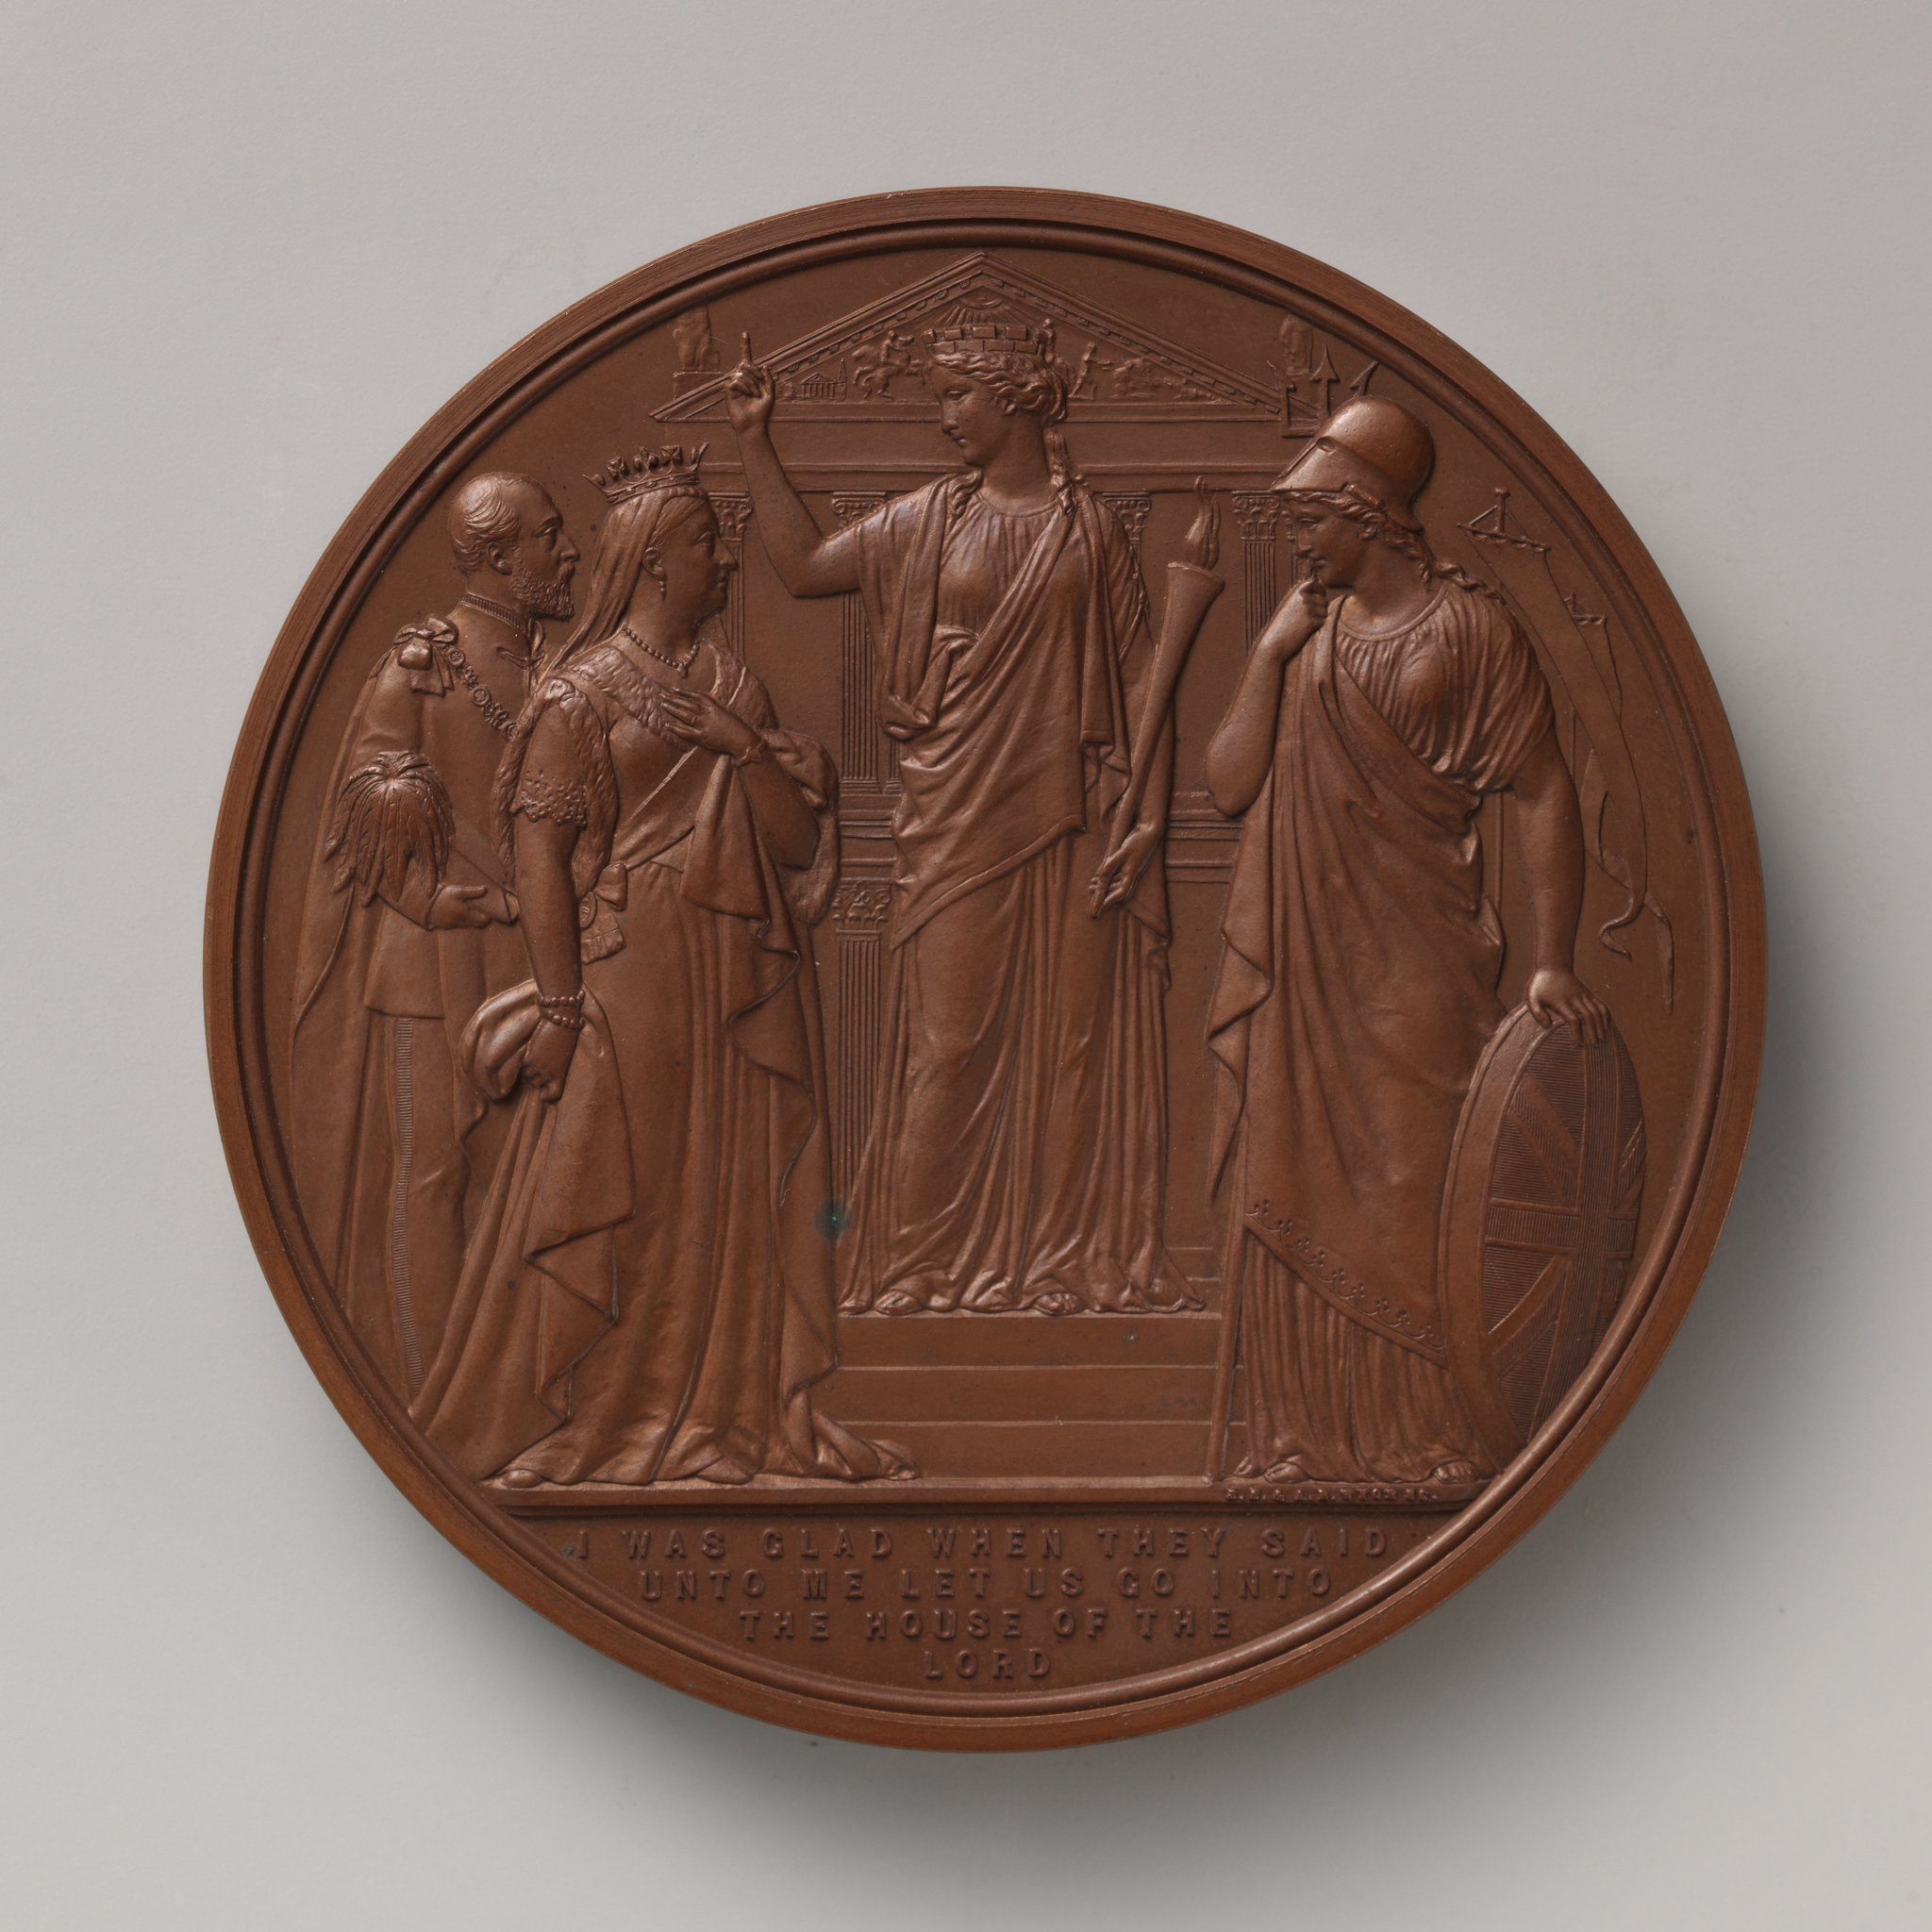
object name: medal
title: Thanksgiving Service at St. Paul's for the Recovery of the Prince of Wales from Typhoid Fever, February 27, 1872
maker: alfred benjamin wyon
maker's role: artist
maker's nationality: british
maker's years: 1837-1884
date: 1872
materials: bronze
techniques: struck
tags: princes,women,medals